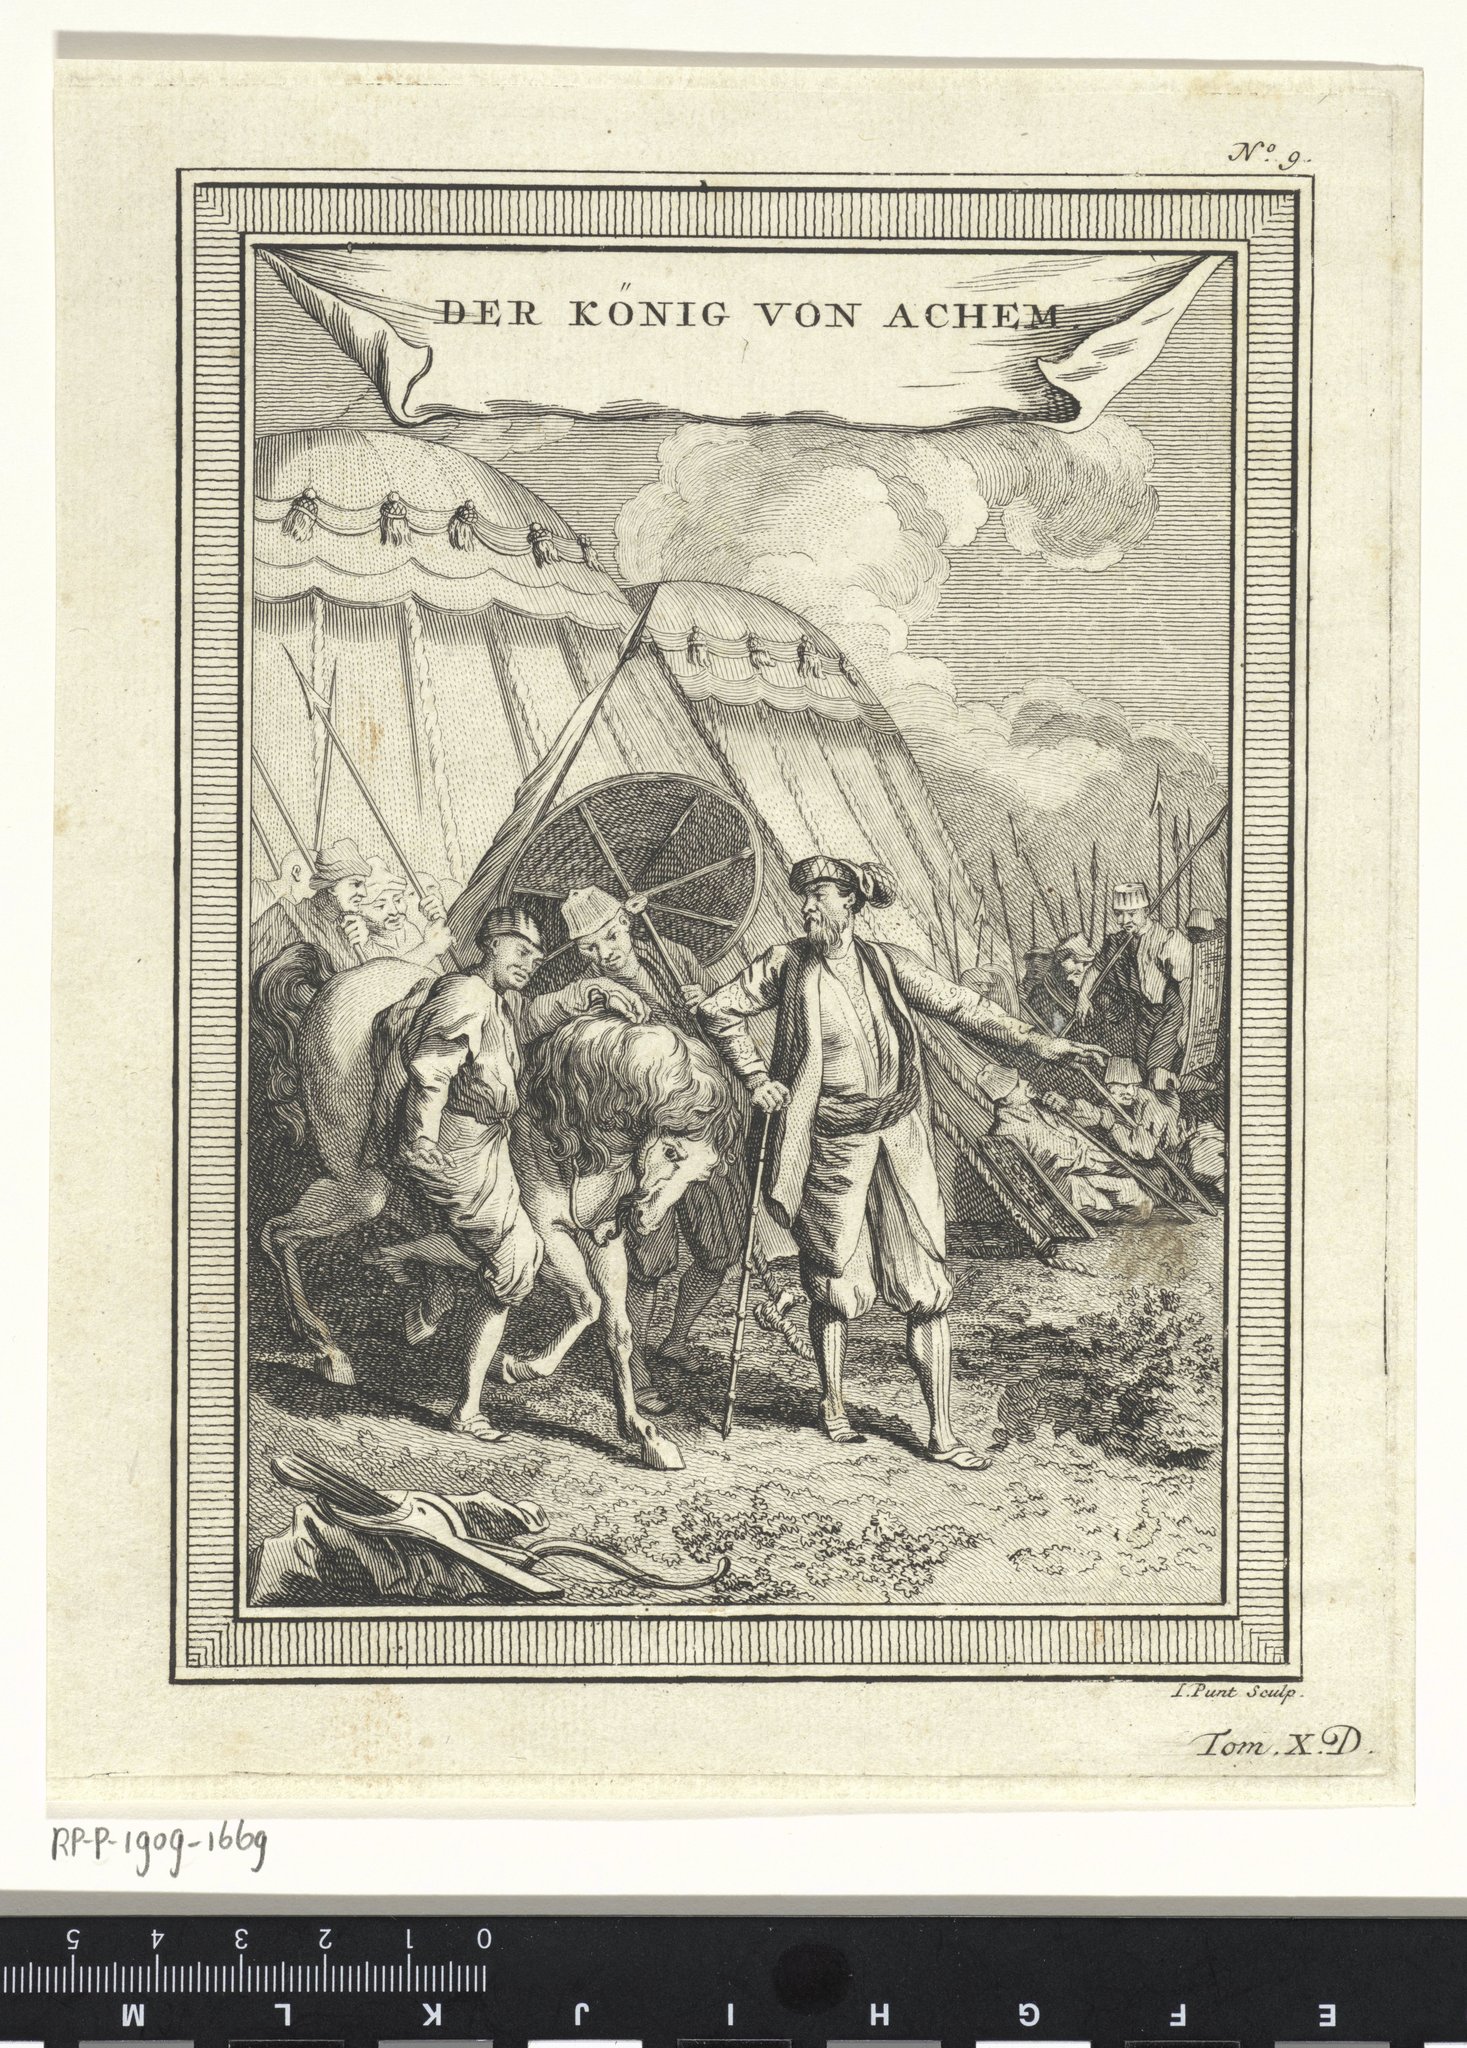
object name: book illustration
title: Der König von Achem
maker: jan punt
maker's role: draughtsman, print maker, publisher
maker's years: 1711-1779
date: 1726-1779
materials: paper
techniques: engraving, etching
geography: amsterdam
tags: (military) camp with tents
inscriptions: collector's mark: Lugt 2228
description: Een paard wordt door twee mannen meegevoerd. De legeraanvoerder wijst hen de weg. Op de achtergrond soldaten in het tentenkamp. Rechtsboven genummerd: N. 9. Rechtsonder gemerkt: Tom. X. D.